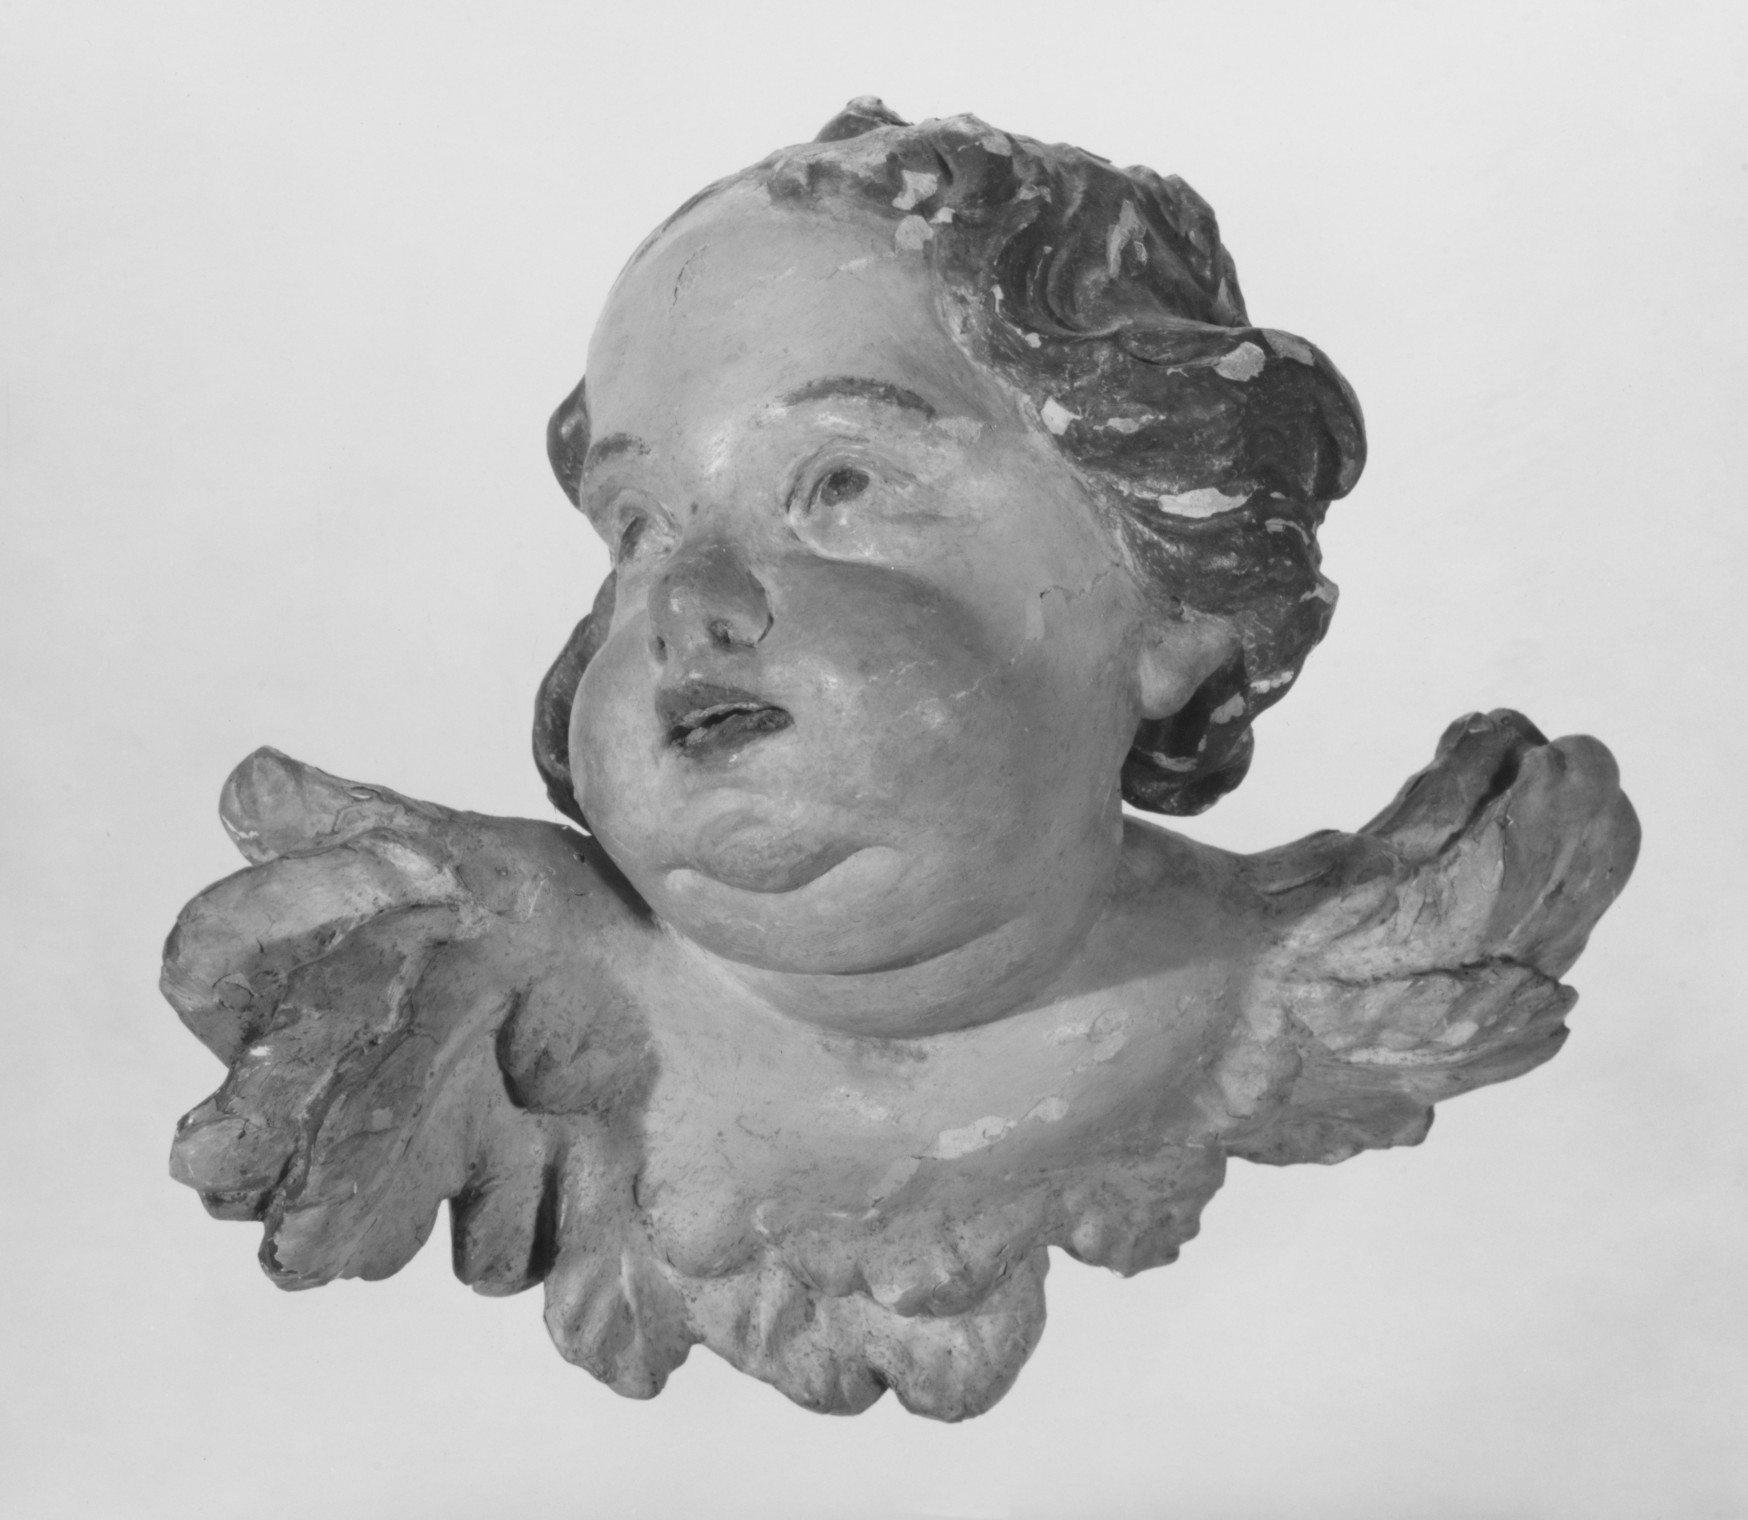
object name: head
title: Head of a cherub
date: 1734-1766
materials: wood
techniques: polychrome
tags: heads,angels